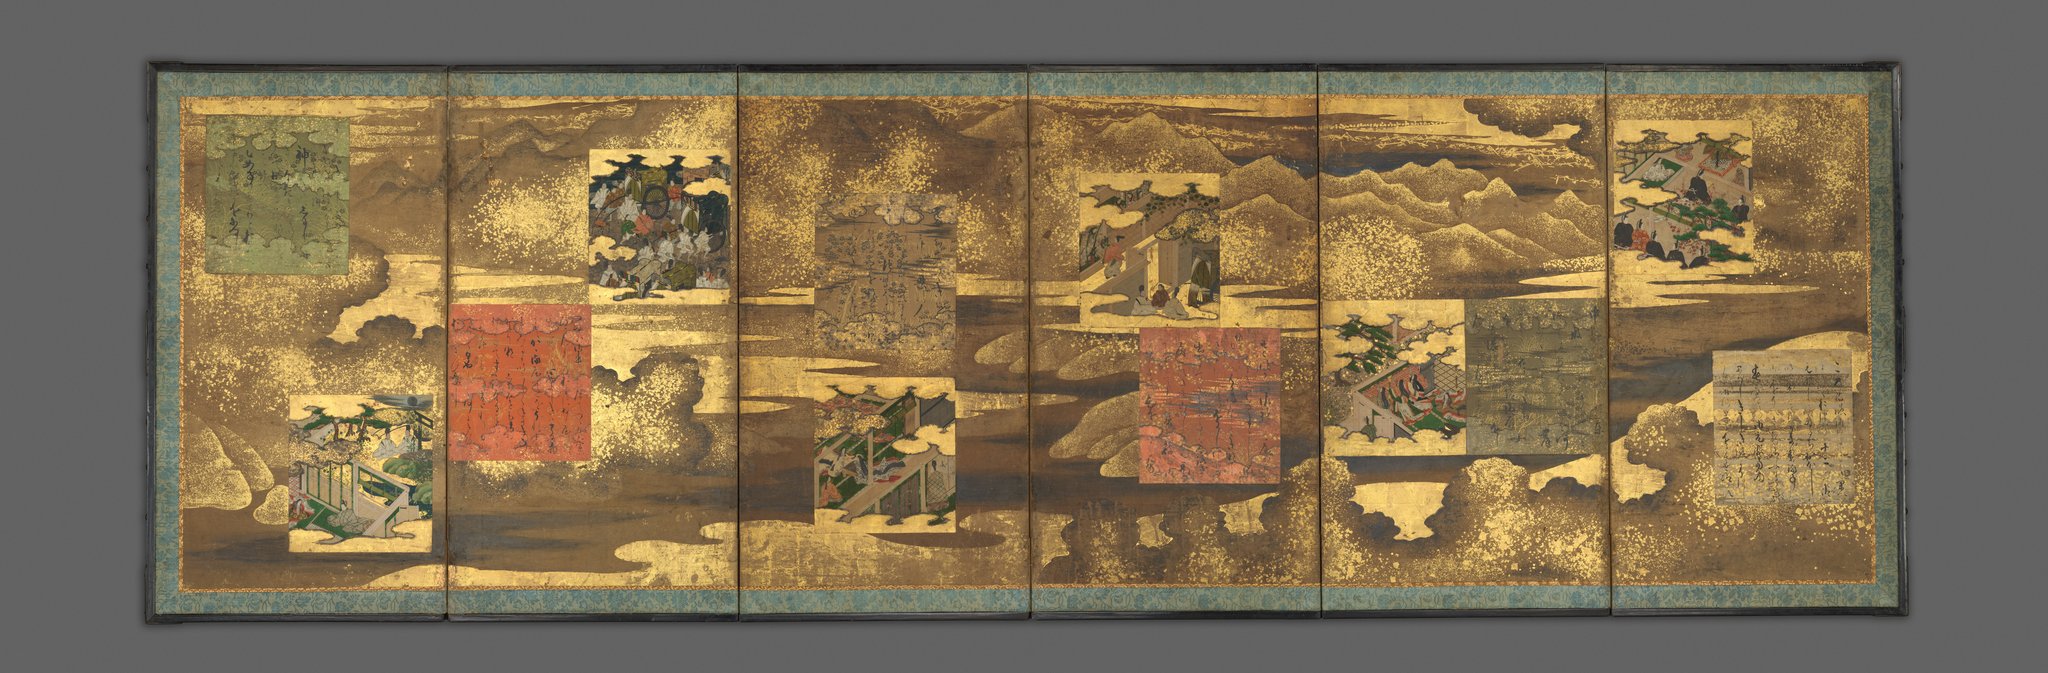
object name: screen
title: Scenes and Calligraphic Excerpts from The Tale of Genji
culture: japanese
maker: tosa school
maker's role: artist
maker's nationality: japanese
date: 1601-1633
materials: gold, ink, panel, paper